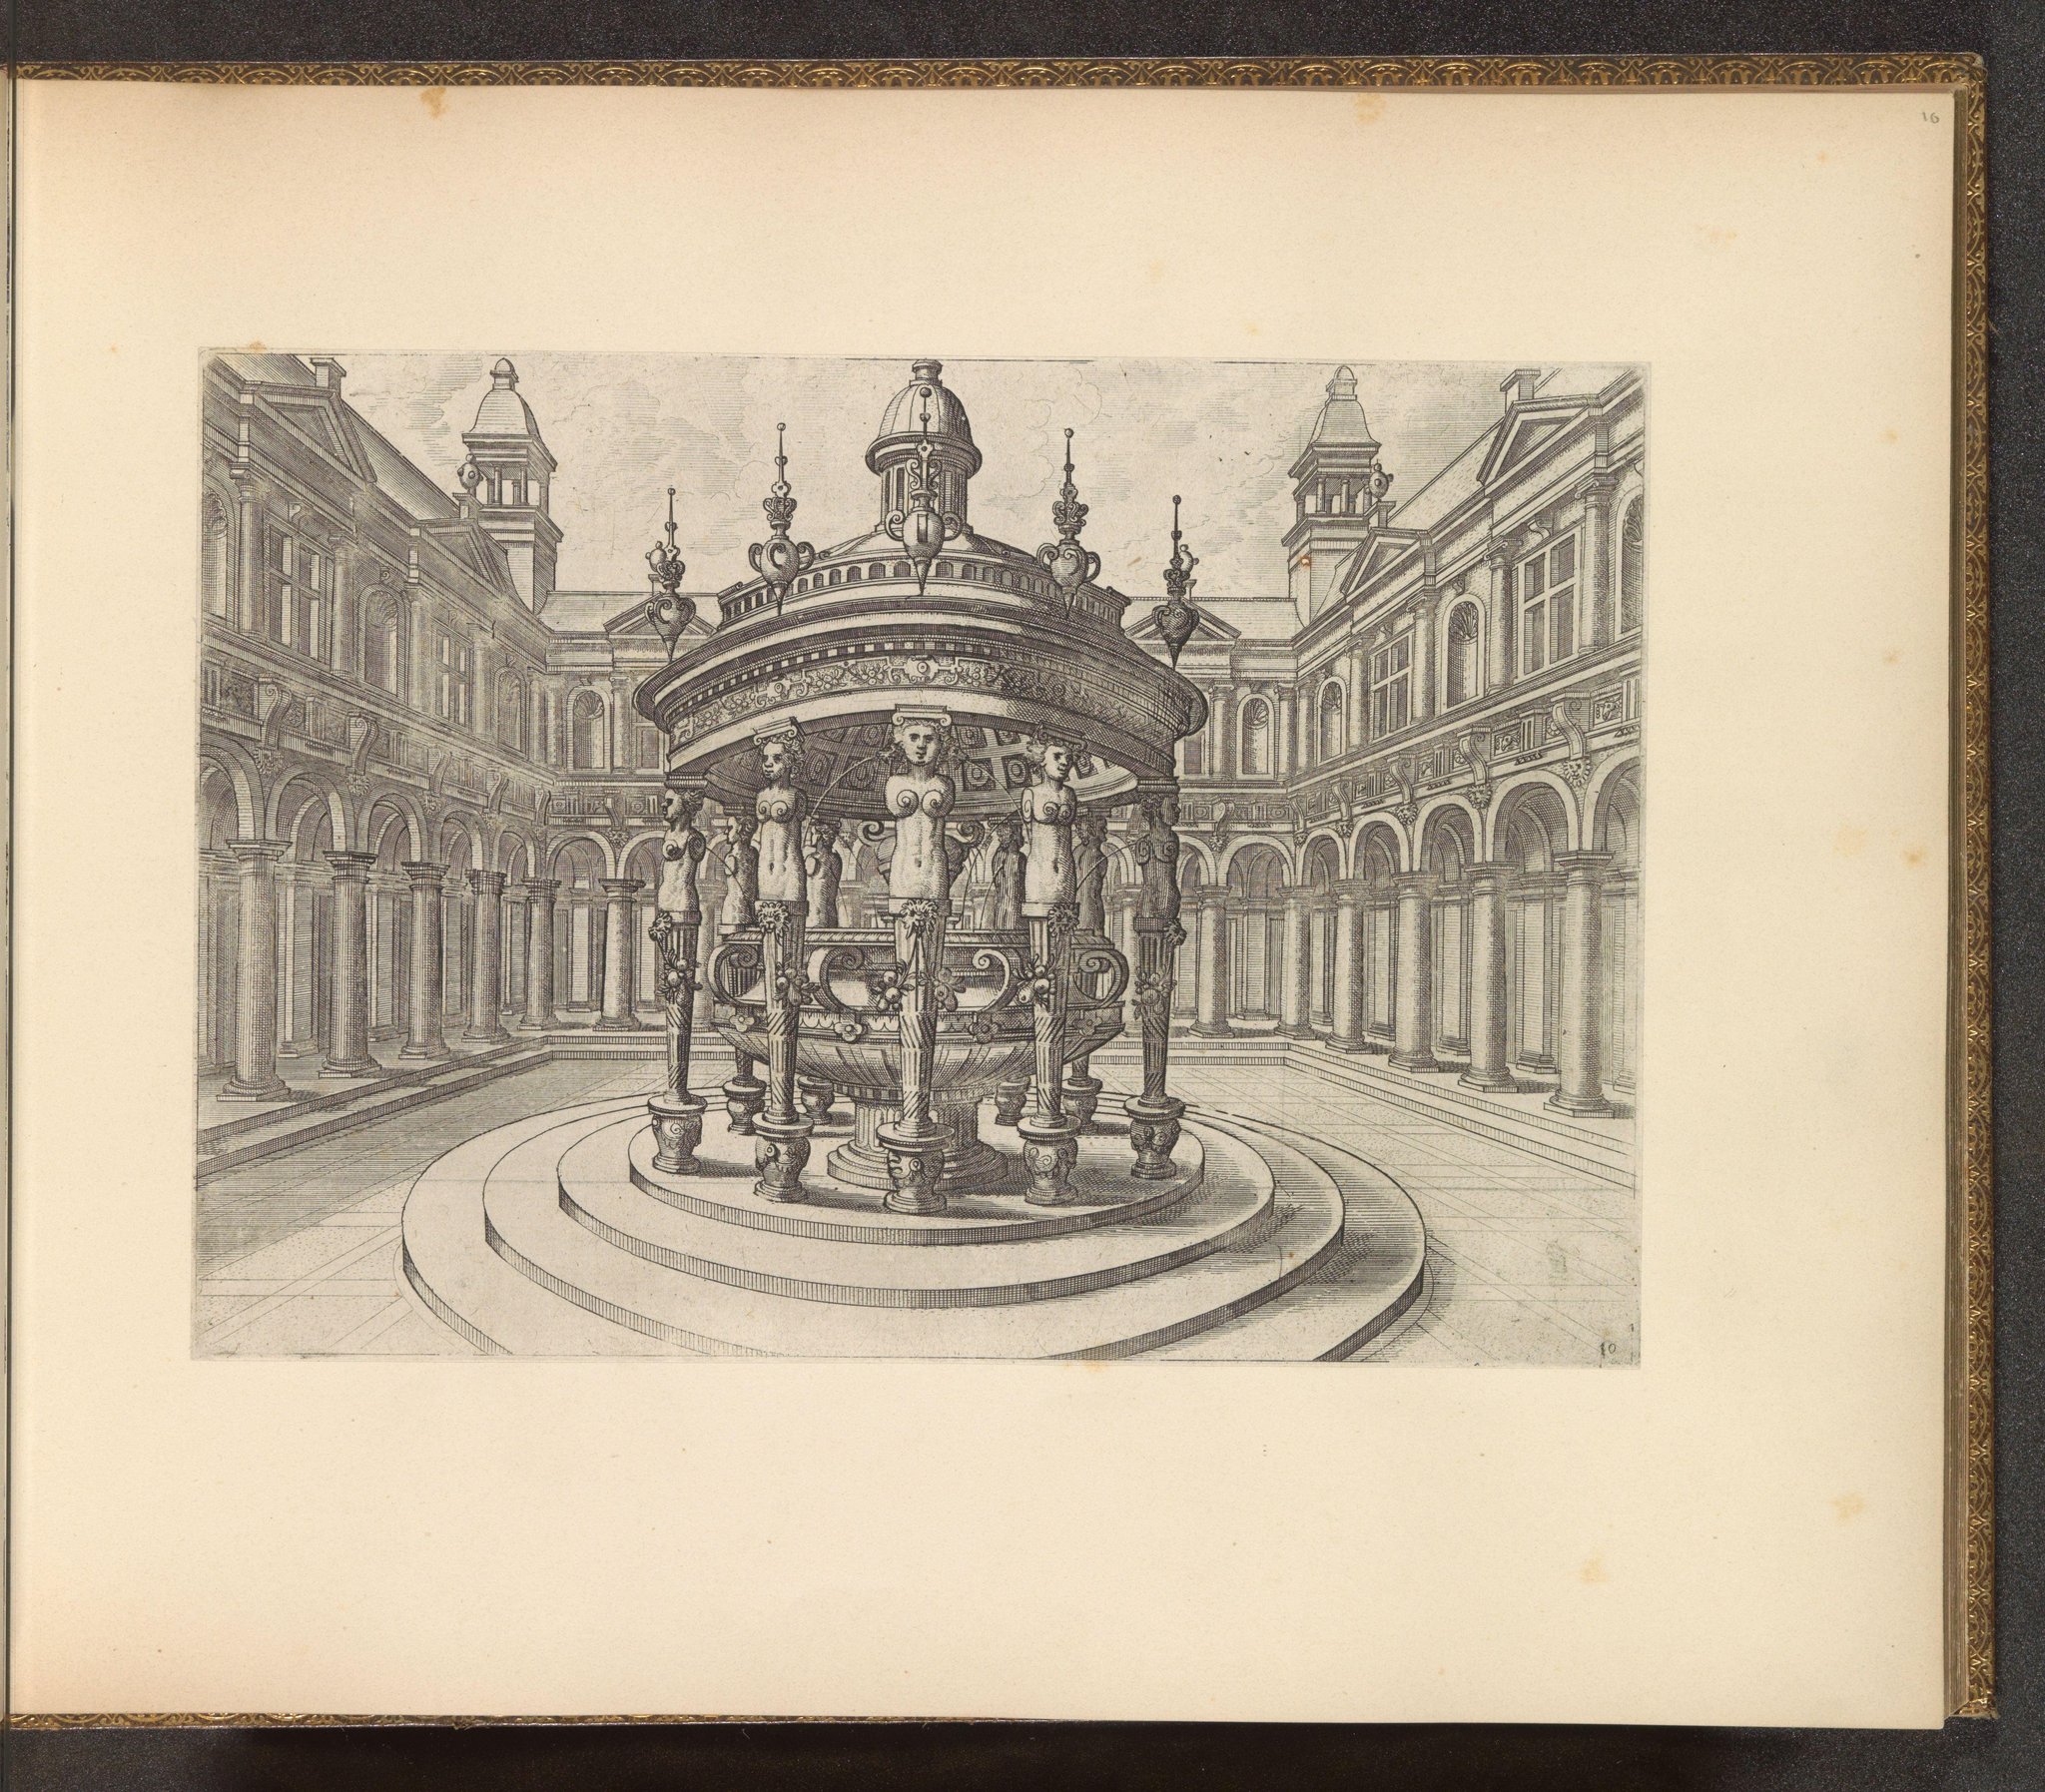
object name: album leaf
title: Artis Perspectiva (...)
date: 1600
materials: paper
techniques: etching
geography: antwerp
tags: ornamental fountain, civic architecture; edifices; dwellings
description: Ombouwde binnenplaats met een vaasvormige fontein onder een koepel, gedragen door vrouwelijke hermen. De prent maakt deel uit van een album.